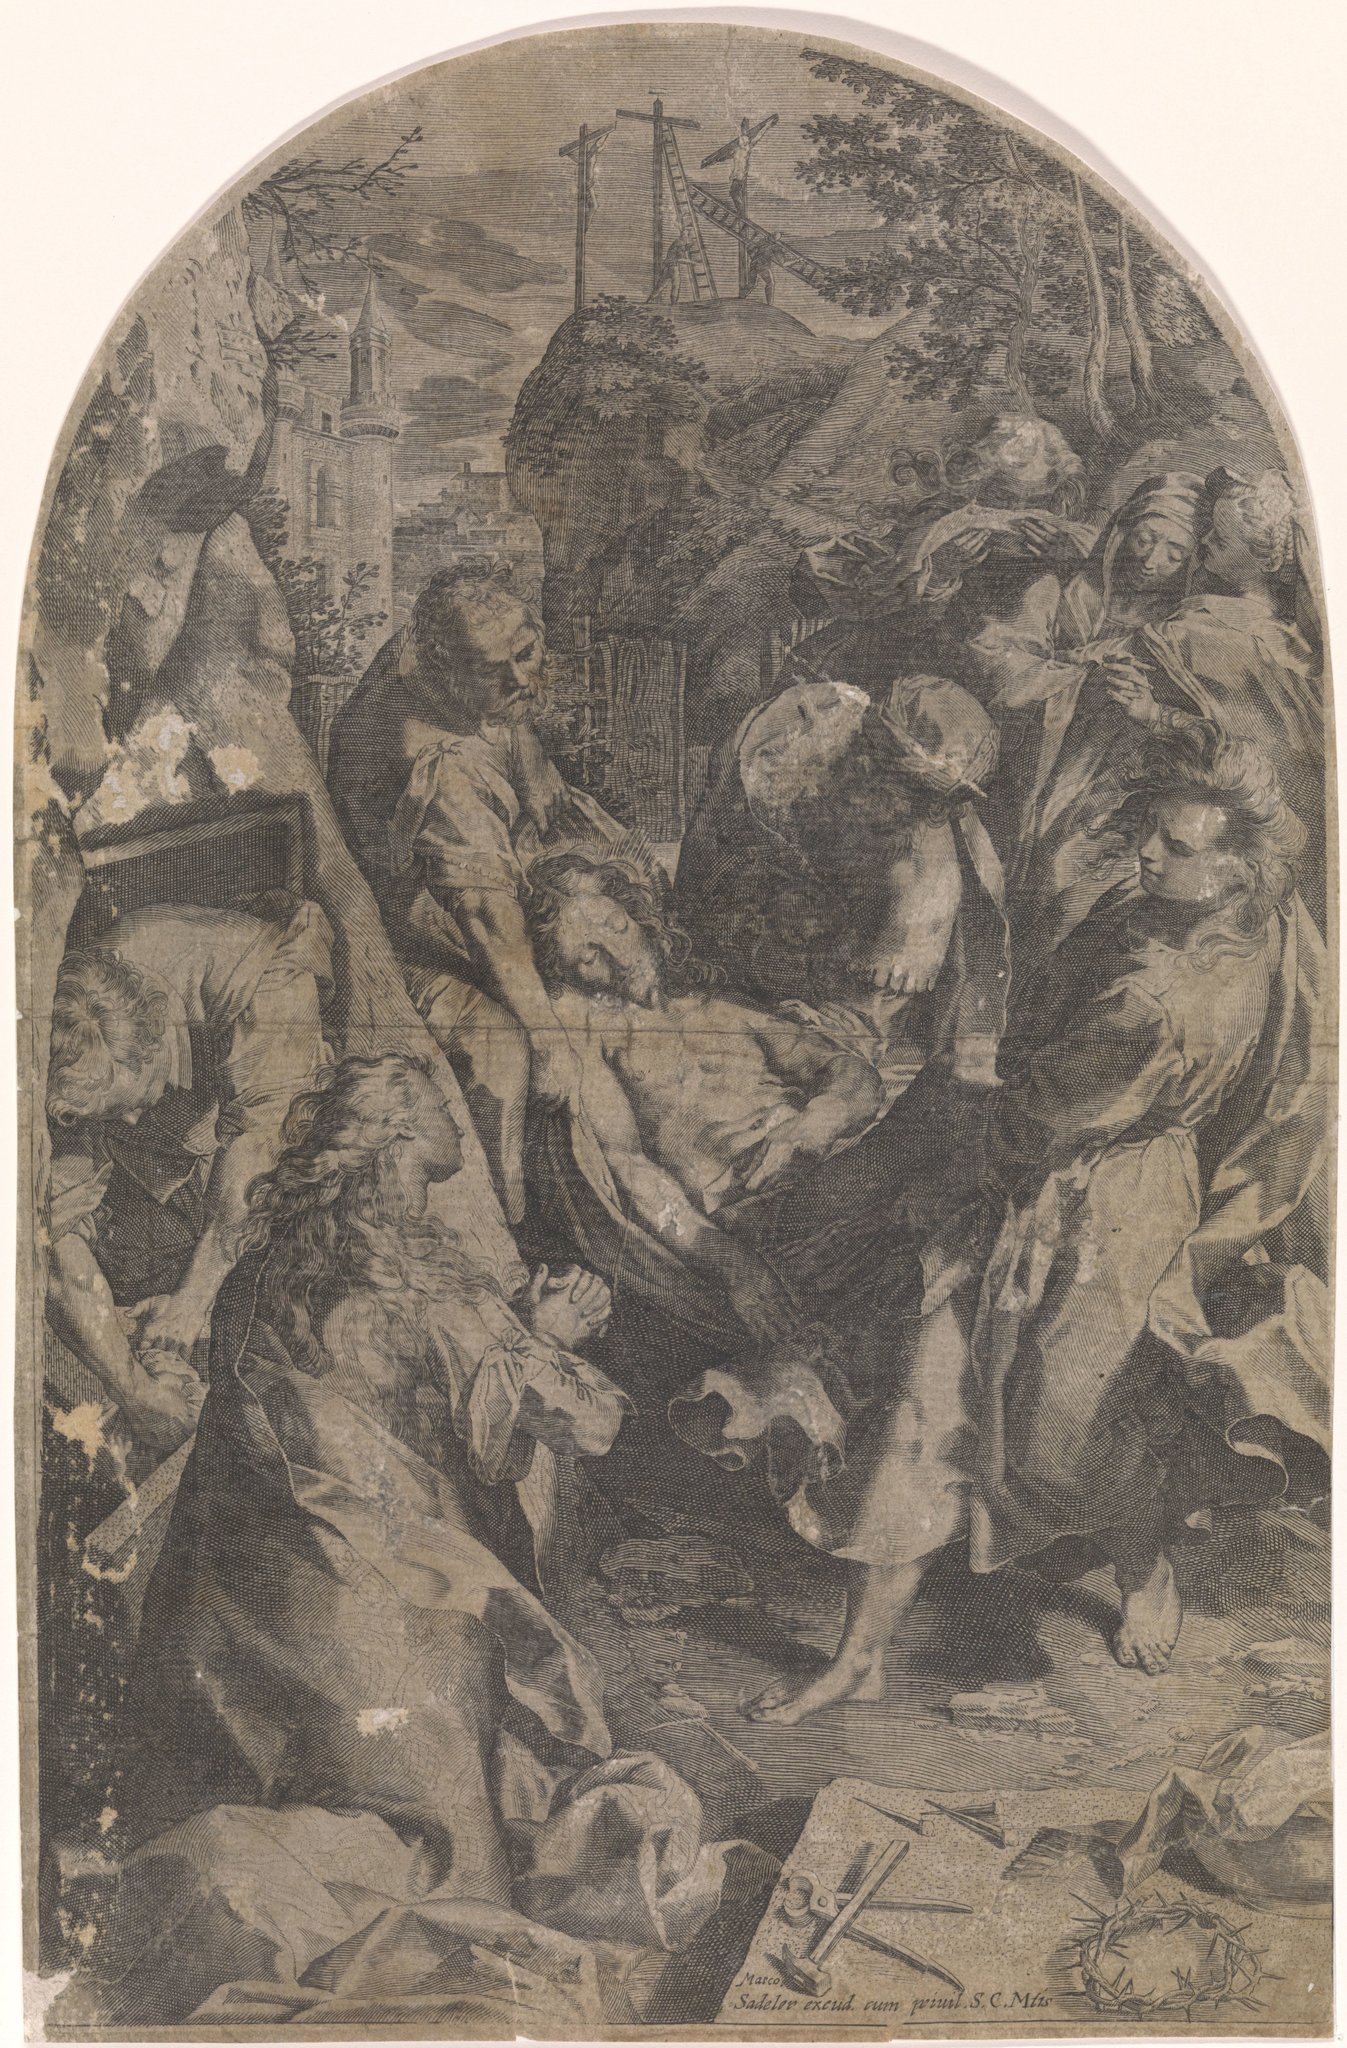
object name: print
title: Graflegging van Christus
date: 1624-1650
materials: paper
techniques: engraving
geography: germany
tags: christ's entombment (possibly by angels)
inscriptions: collector's mark: Lugt 2228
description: Christus wordt door zijn familie en vrienden in een graftombe gelegd. Op de voorgrond links zit de geknielde Maria Magdalena. Op de voorgrond rechts liggen enkele passiewerktuigen van Christus (hamer, tang, spijkers, doornenkroon). Op de achtergrond de kruisberg.